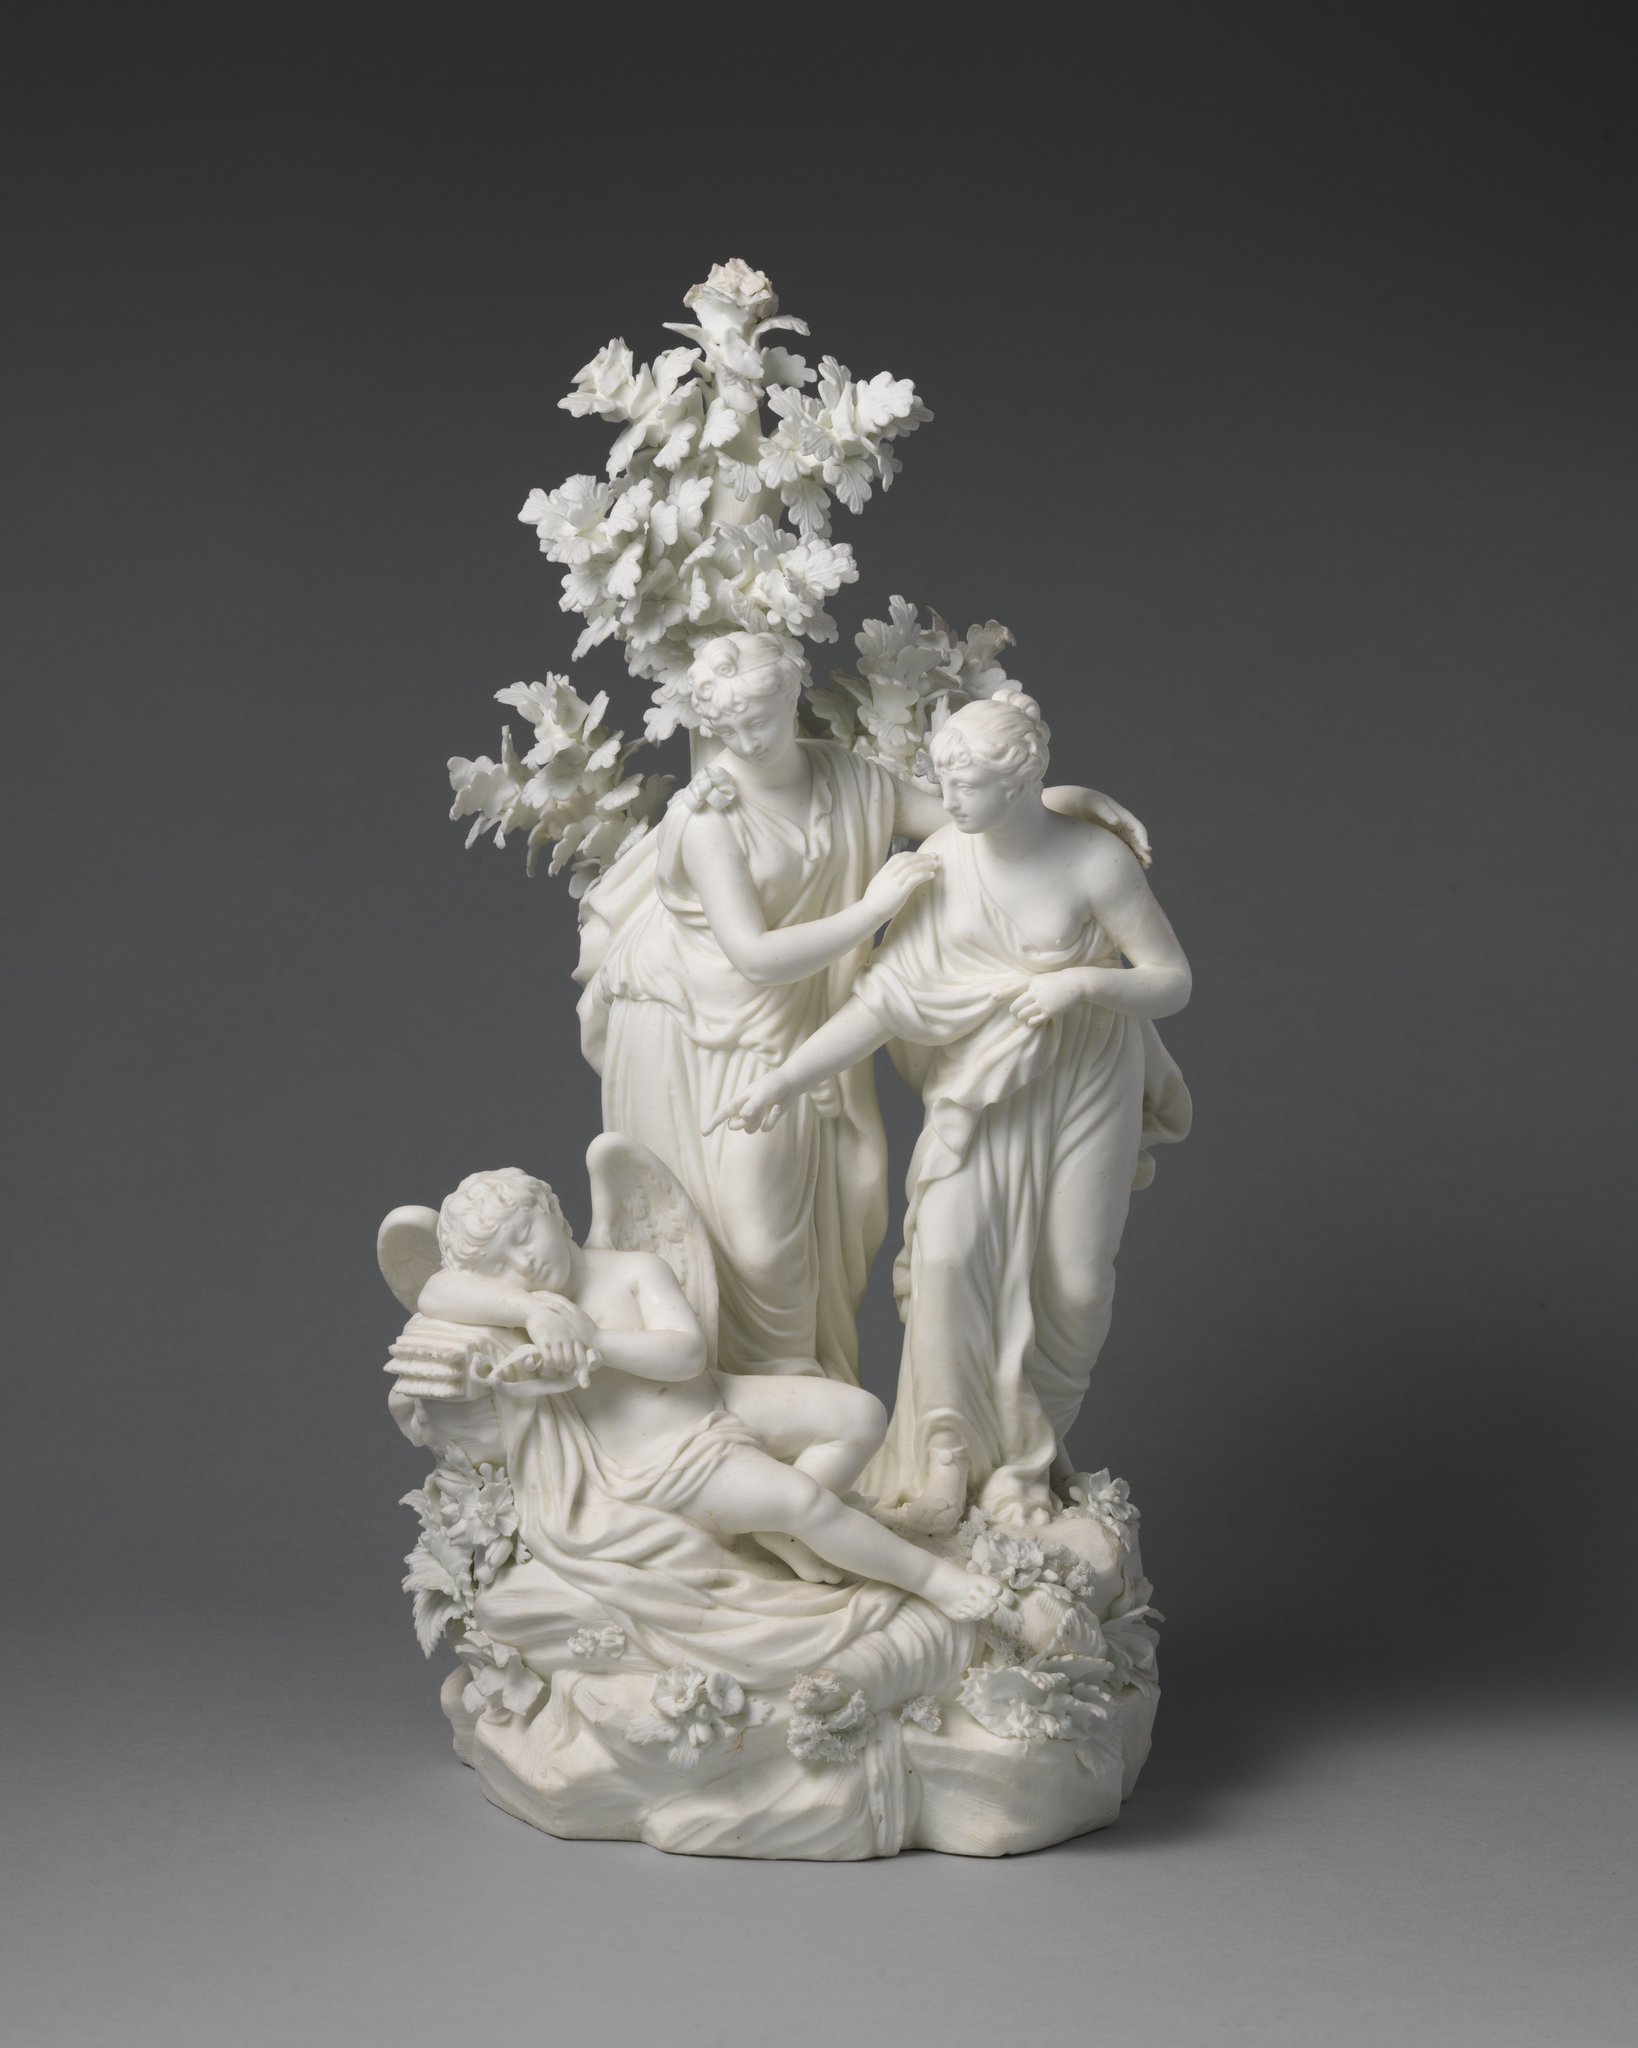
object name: group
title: Virgins Awaking Cupid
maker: derby porcelain manufactory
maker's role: factory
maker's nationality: british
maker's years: 1751-1785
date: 1780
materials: biscuit, paste, porcelain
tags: women,cupid,flowers,leaves